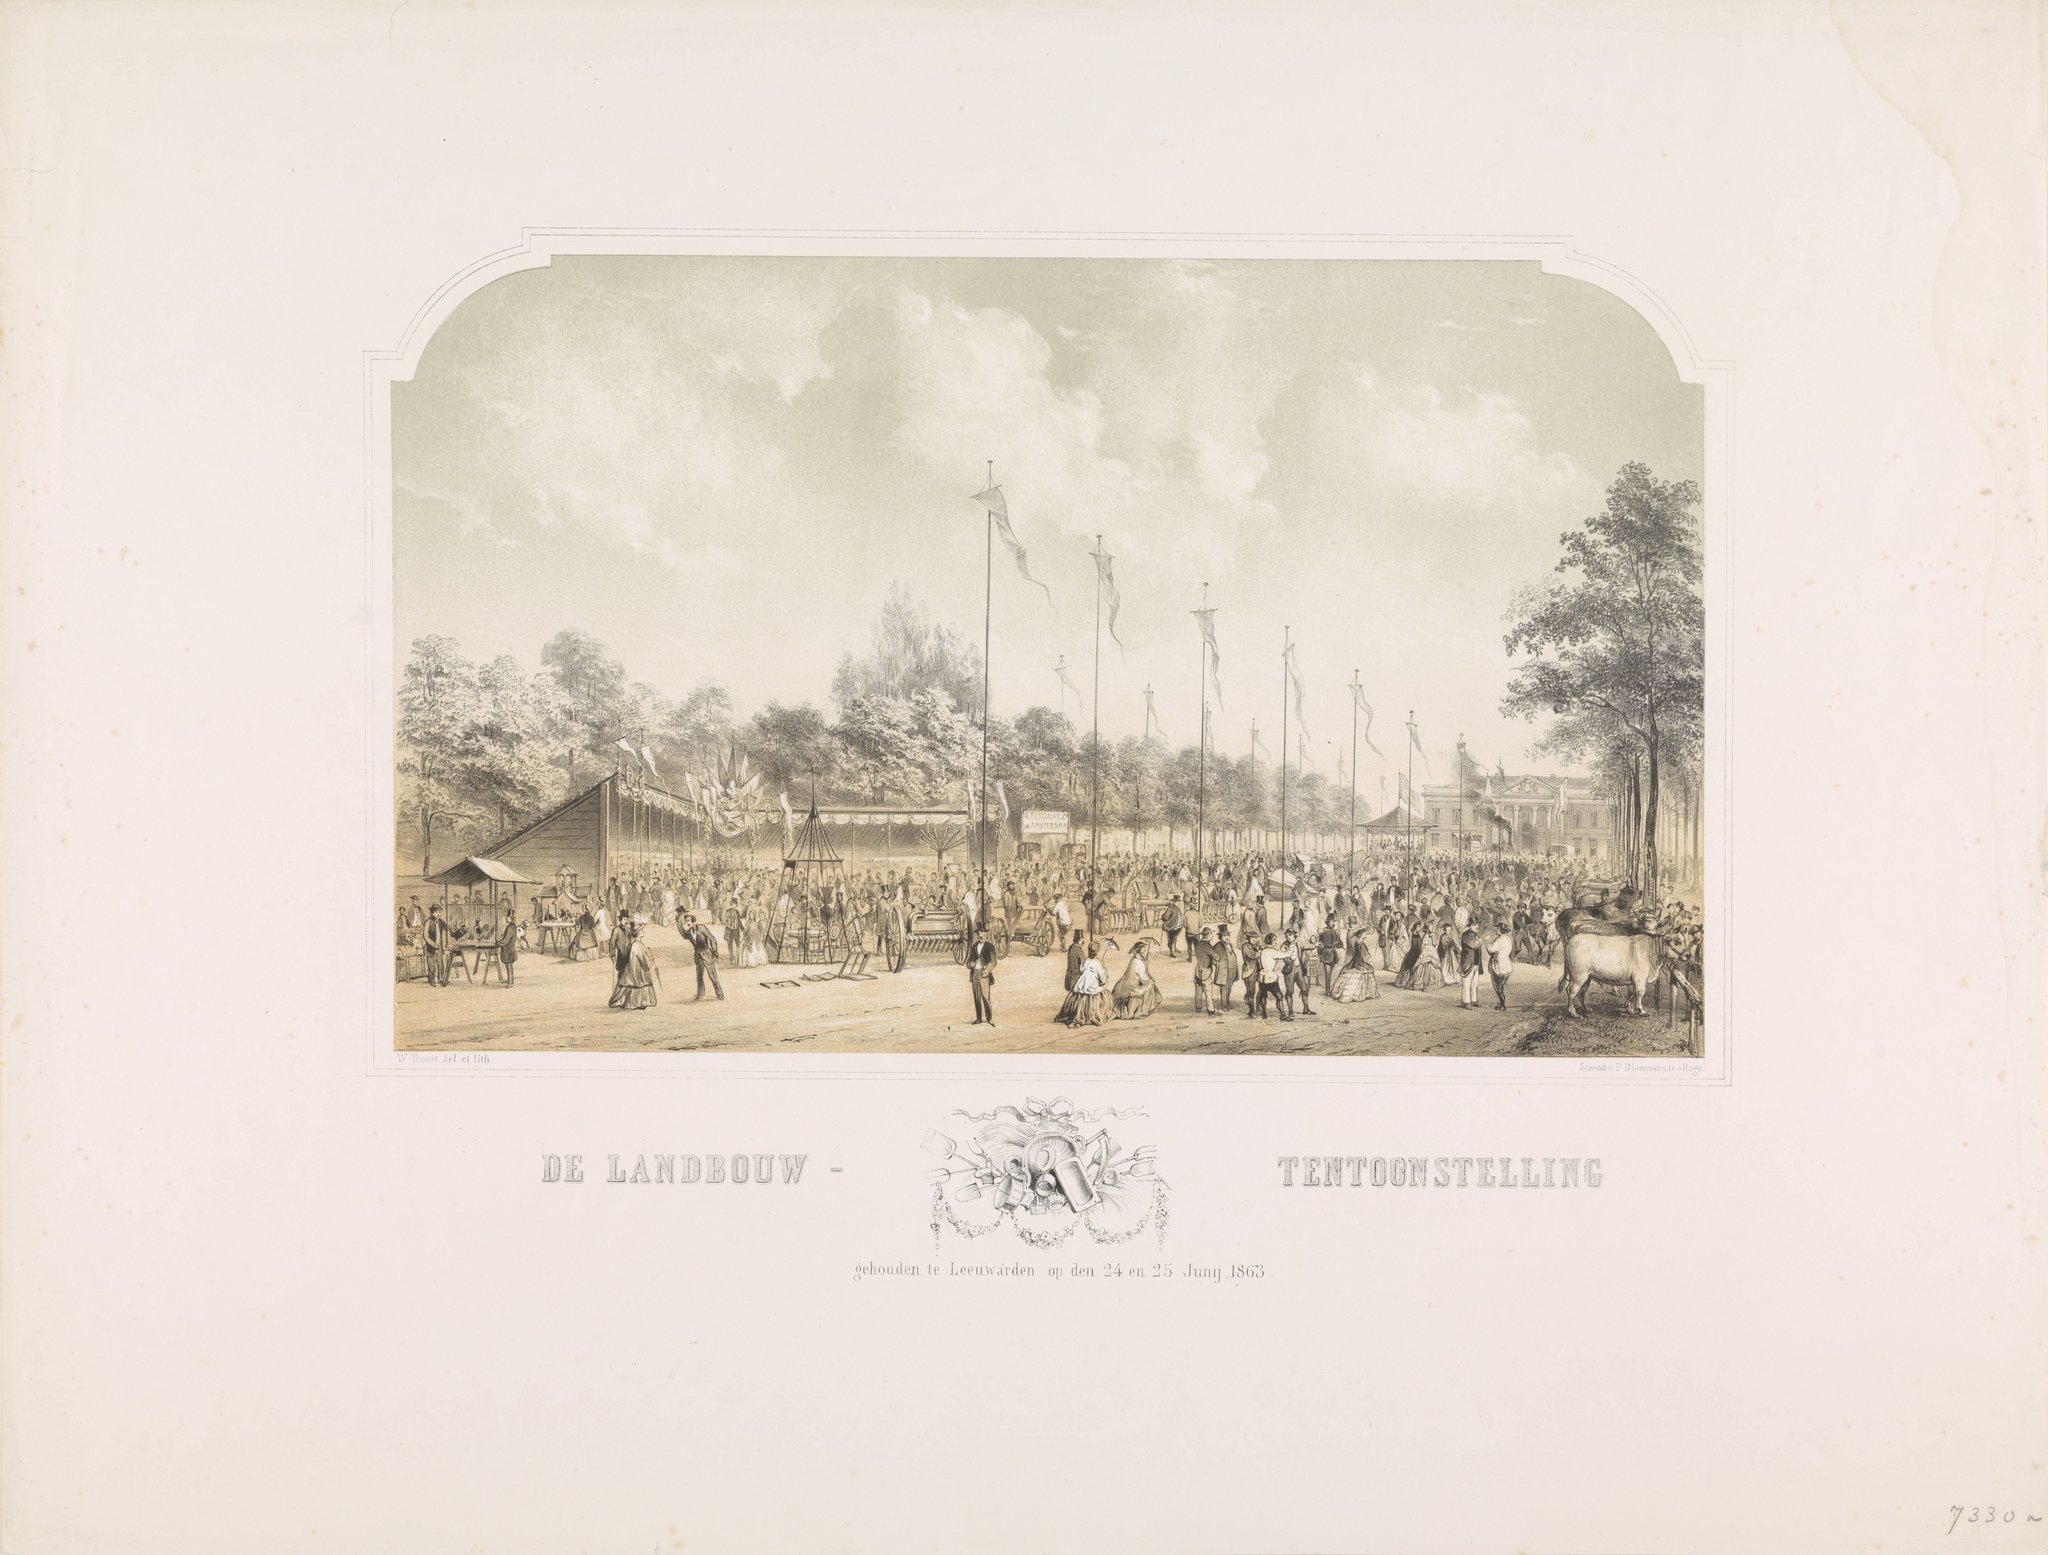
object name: print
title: De Landbouw-Tentoonstelling gehouden te Leeuwarden op den 24 en 25 Junij 1863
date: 1863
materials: paper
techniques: tone lithography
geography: the hague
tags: (annual) fair, trade fair, agricultural implements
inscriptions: collector's mark: Lugt 2228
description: Gezicht op de Landbouwtentoonstelling gehouden voor het Paleis van Justitie op het Zaailand (Wilhelminaplein) te Leeuwarden, op 24 en 25 juni 1863. De bezoekers wandelen tussen de tentoongestelde landbouwmachines, rechts vee, links een tribune. Onderaan in de marge een vignet met agrarische objecten.